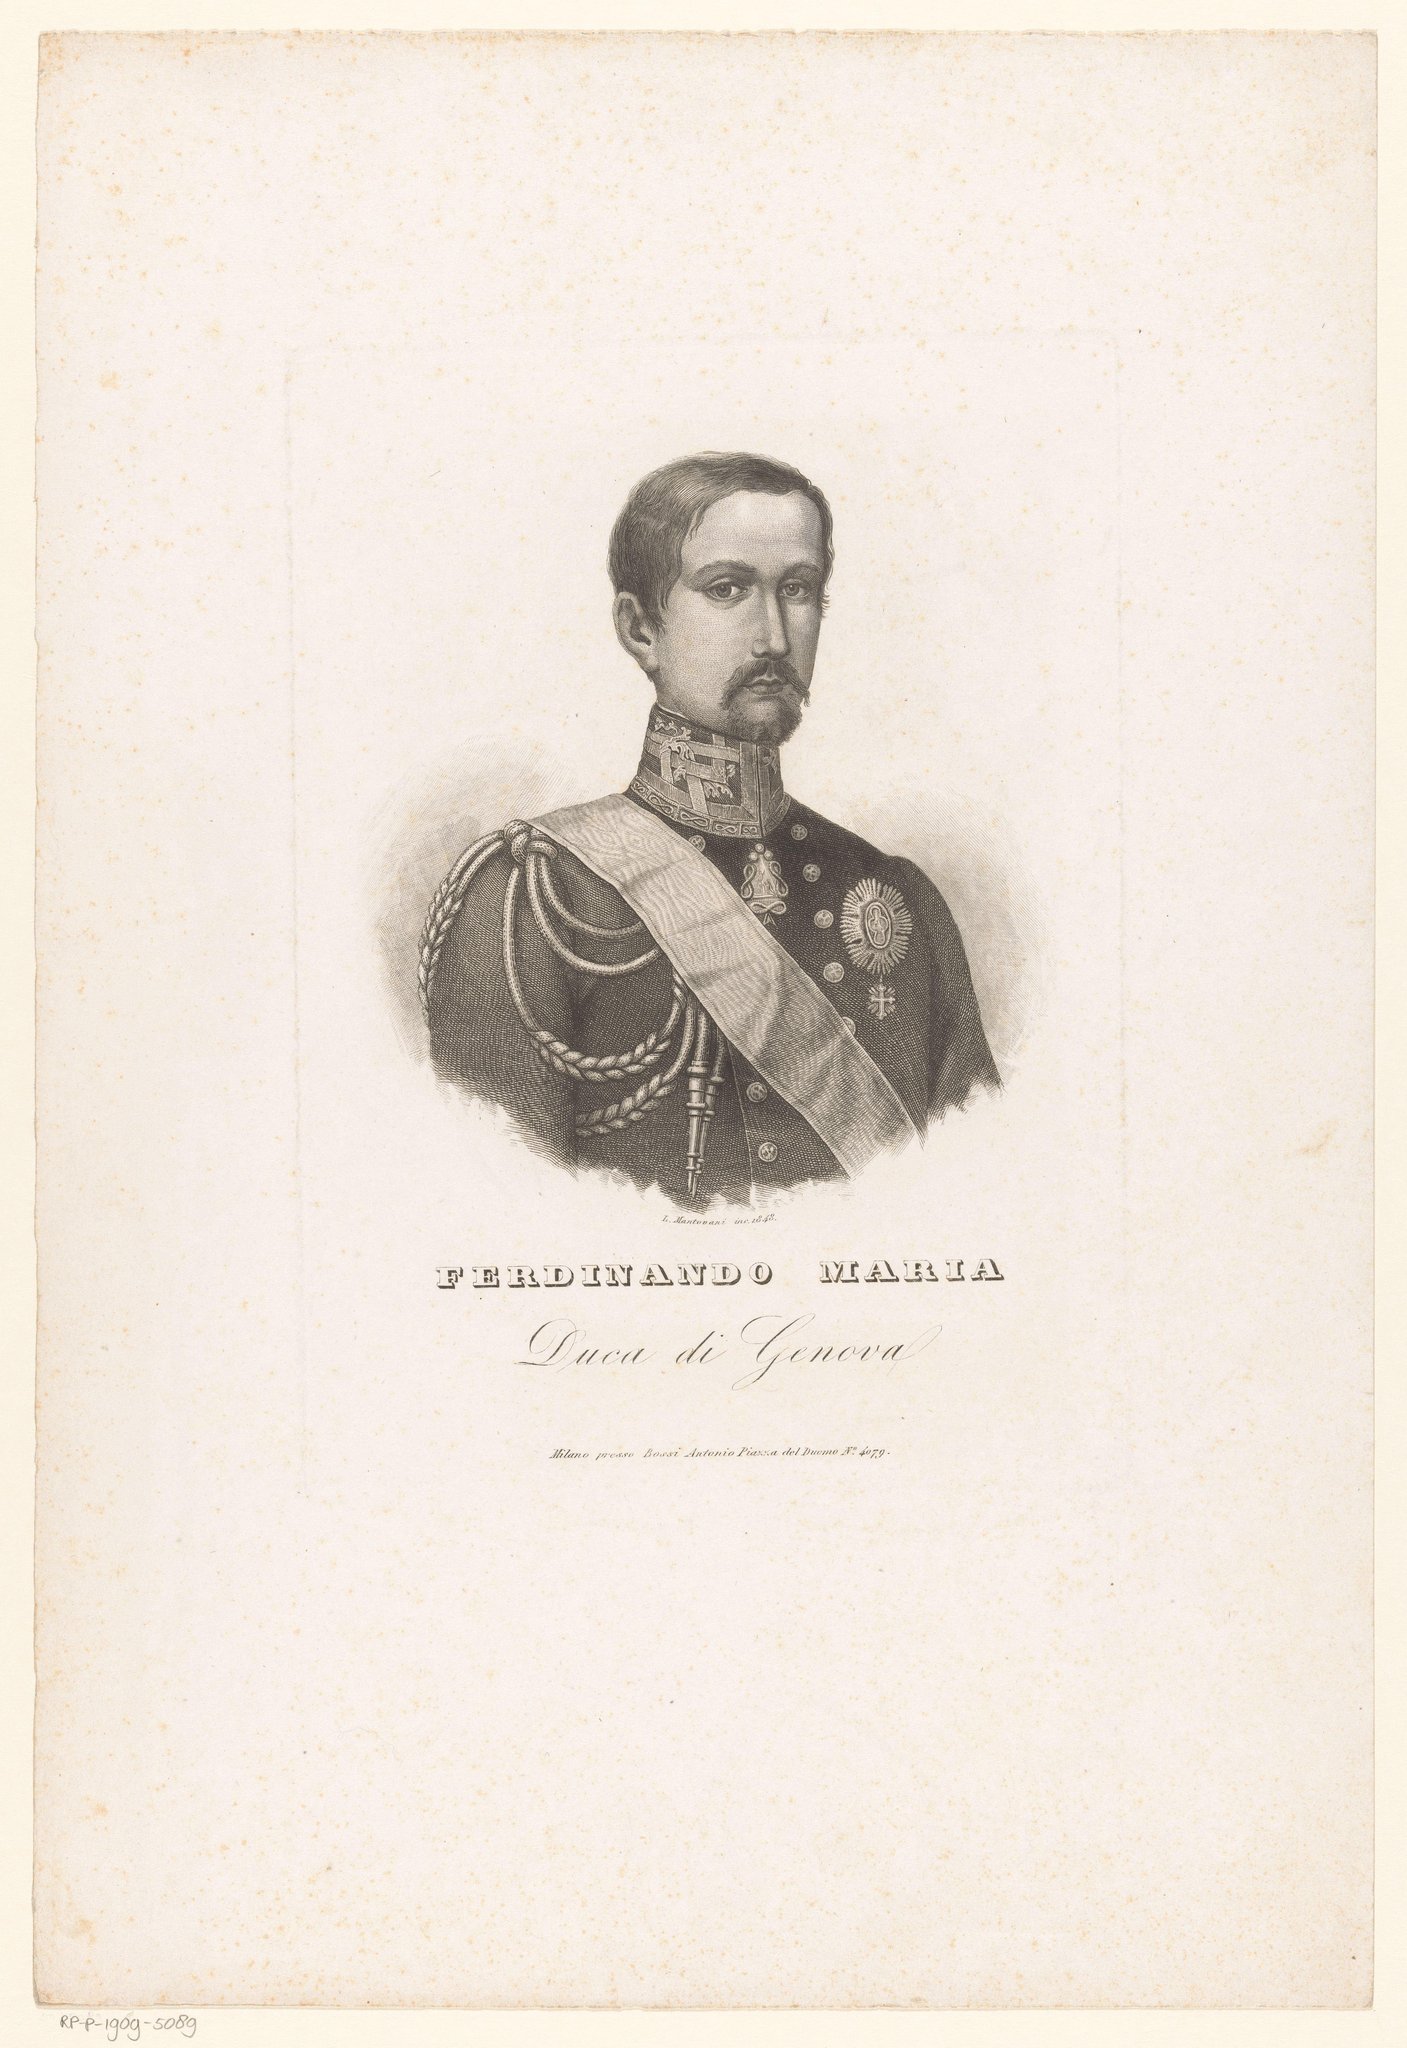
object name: print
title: Portret van Ferdinand Maria van Savoye-Carignano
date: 1848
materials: paper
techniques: engraving, etching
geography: milan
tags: prince, historical persons, ruler, sovereign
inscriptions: collector's mark: Lugt 2228